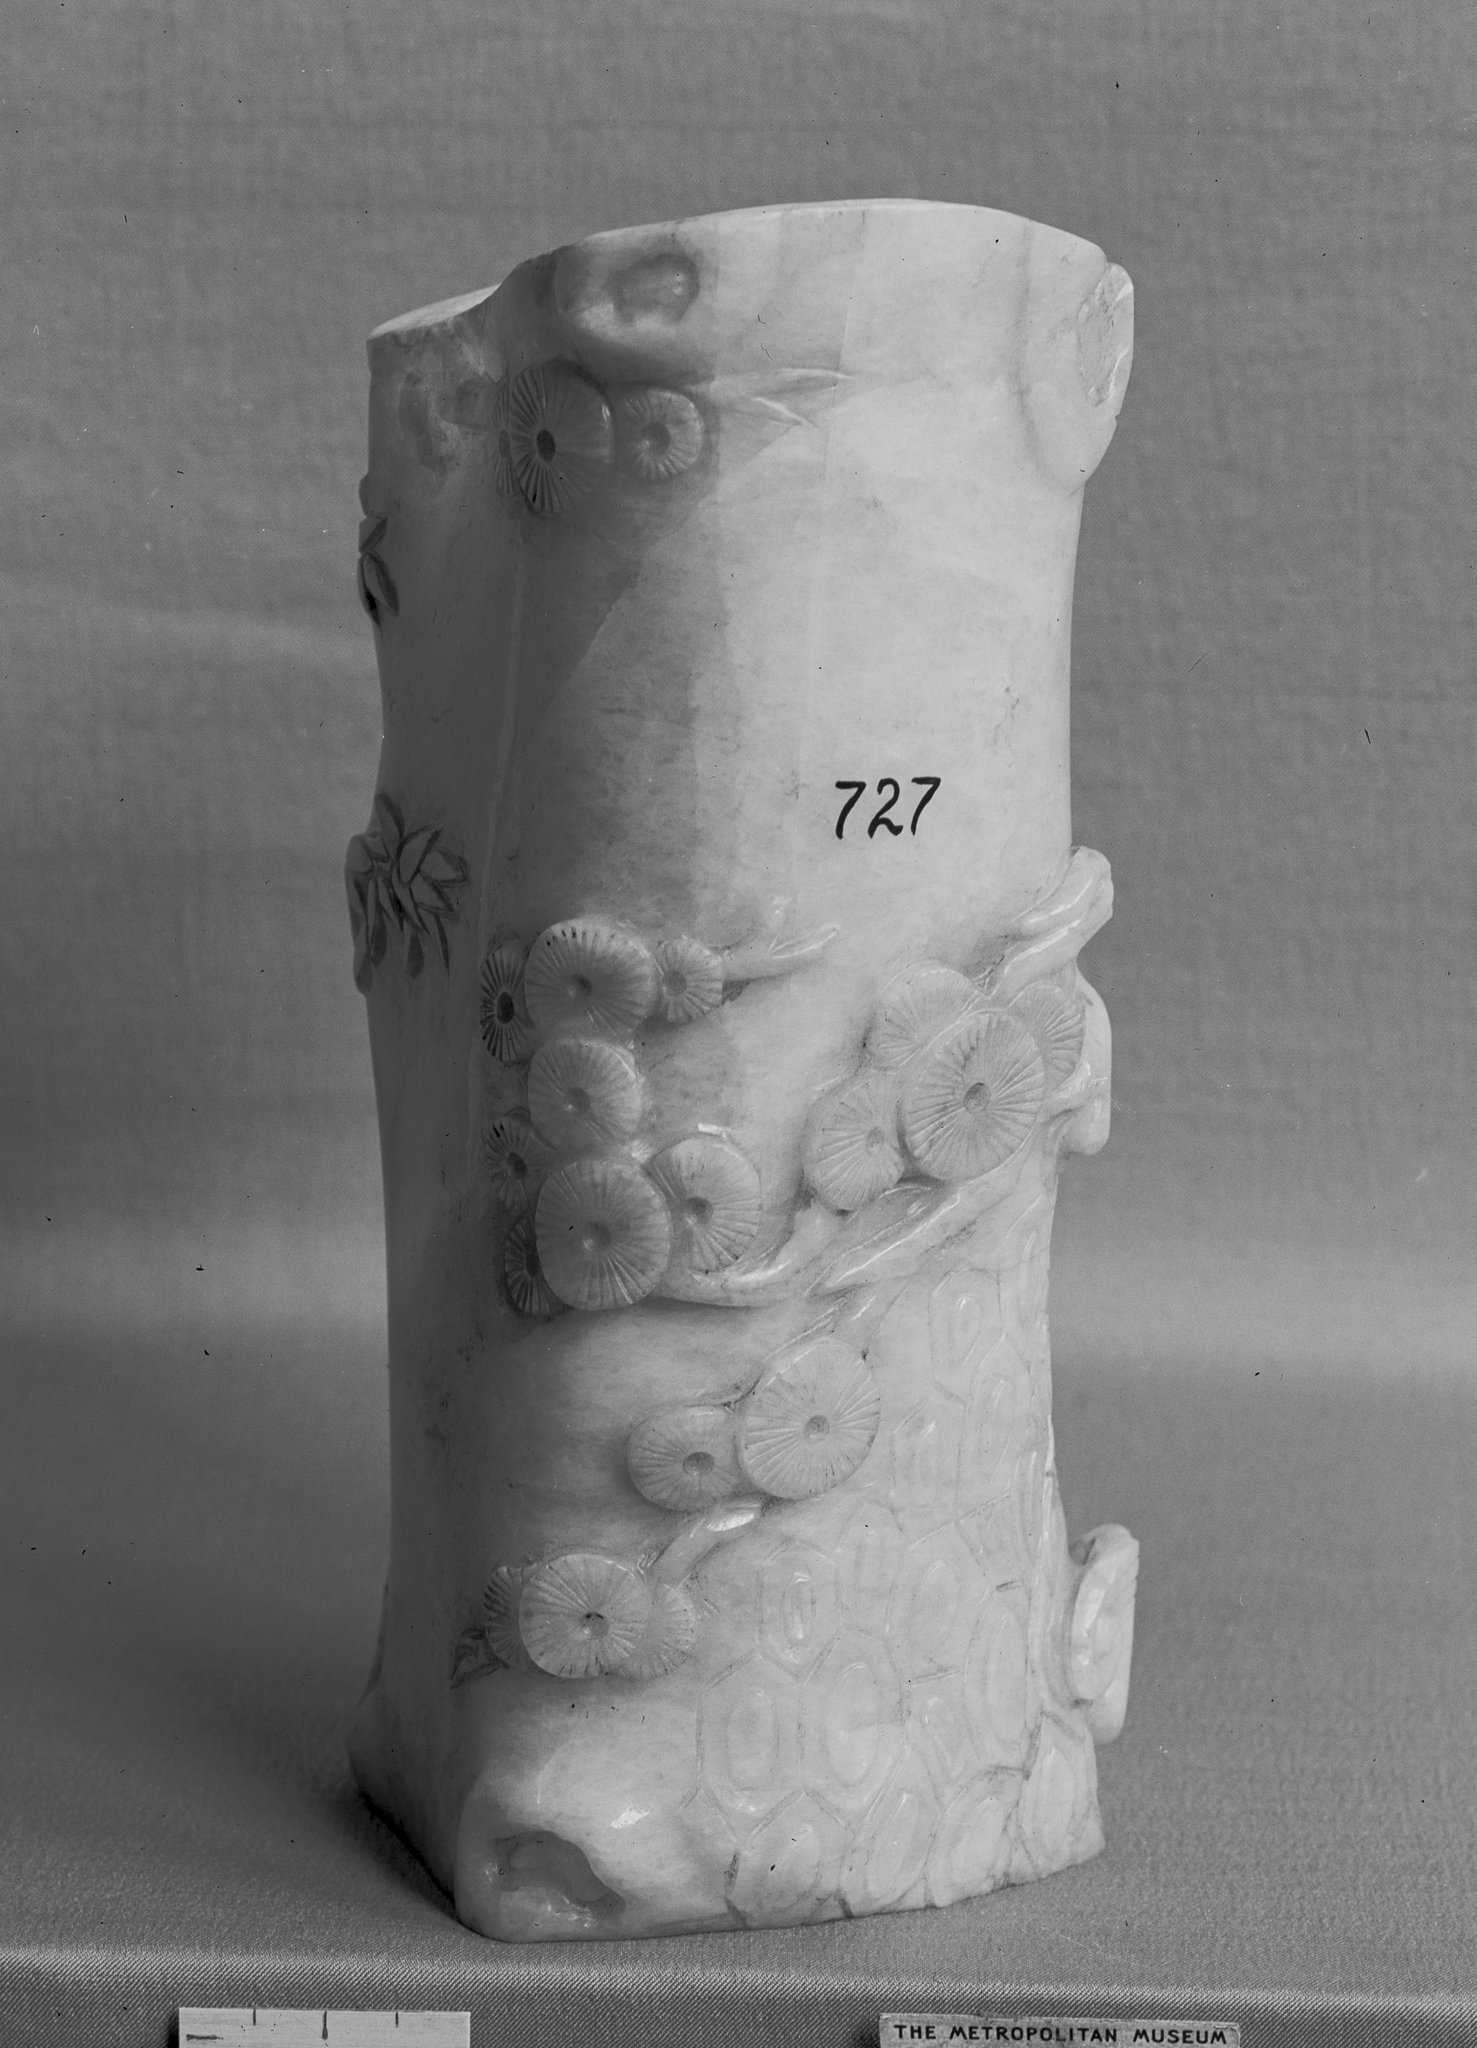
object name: flower vase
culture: chinese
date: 1796-1875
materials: gemstone, jade